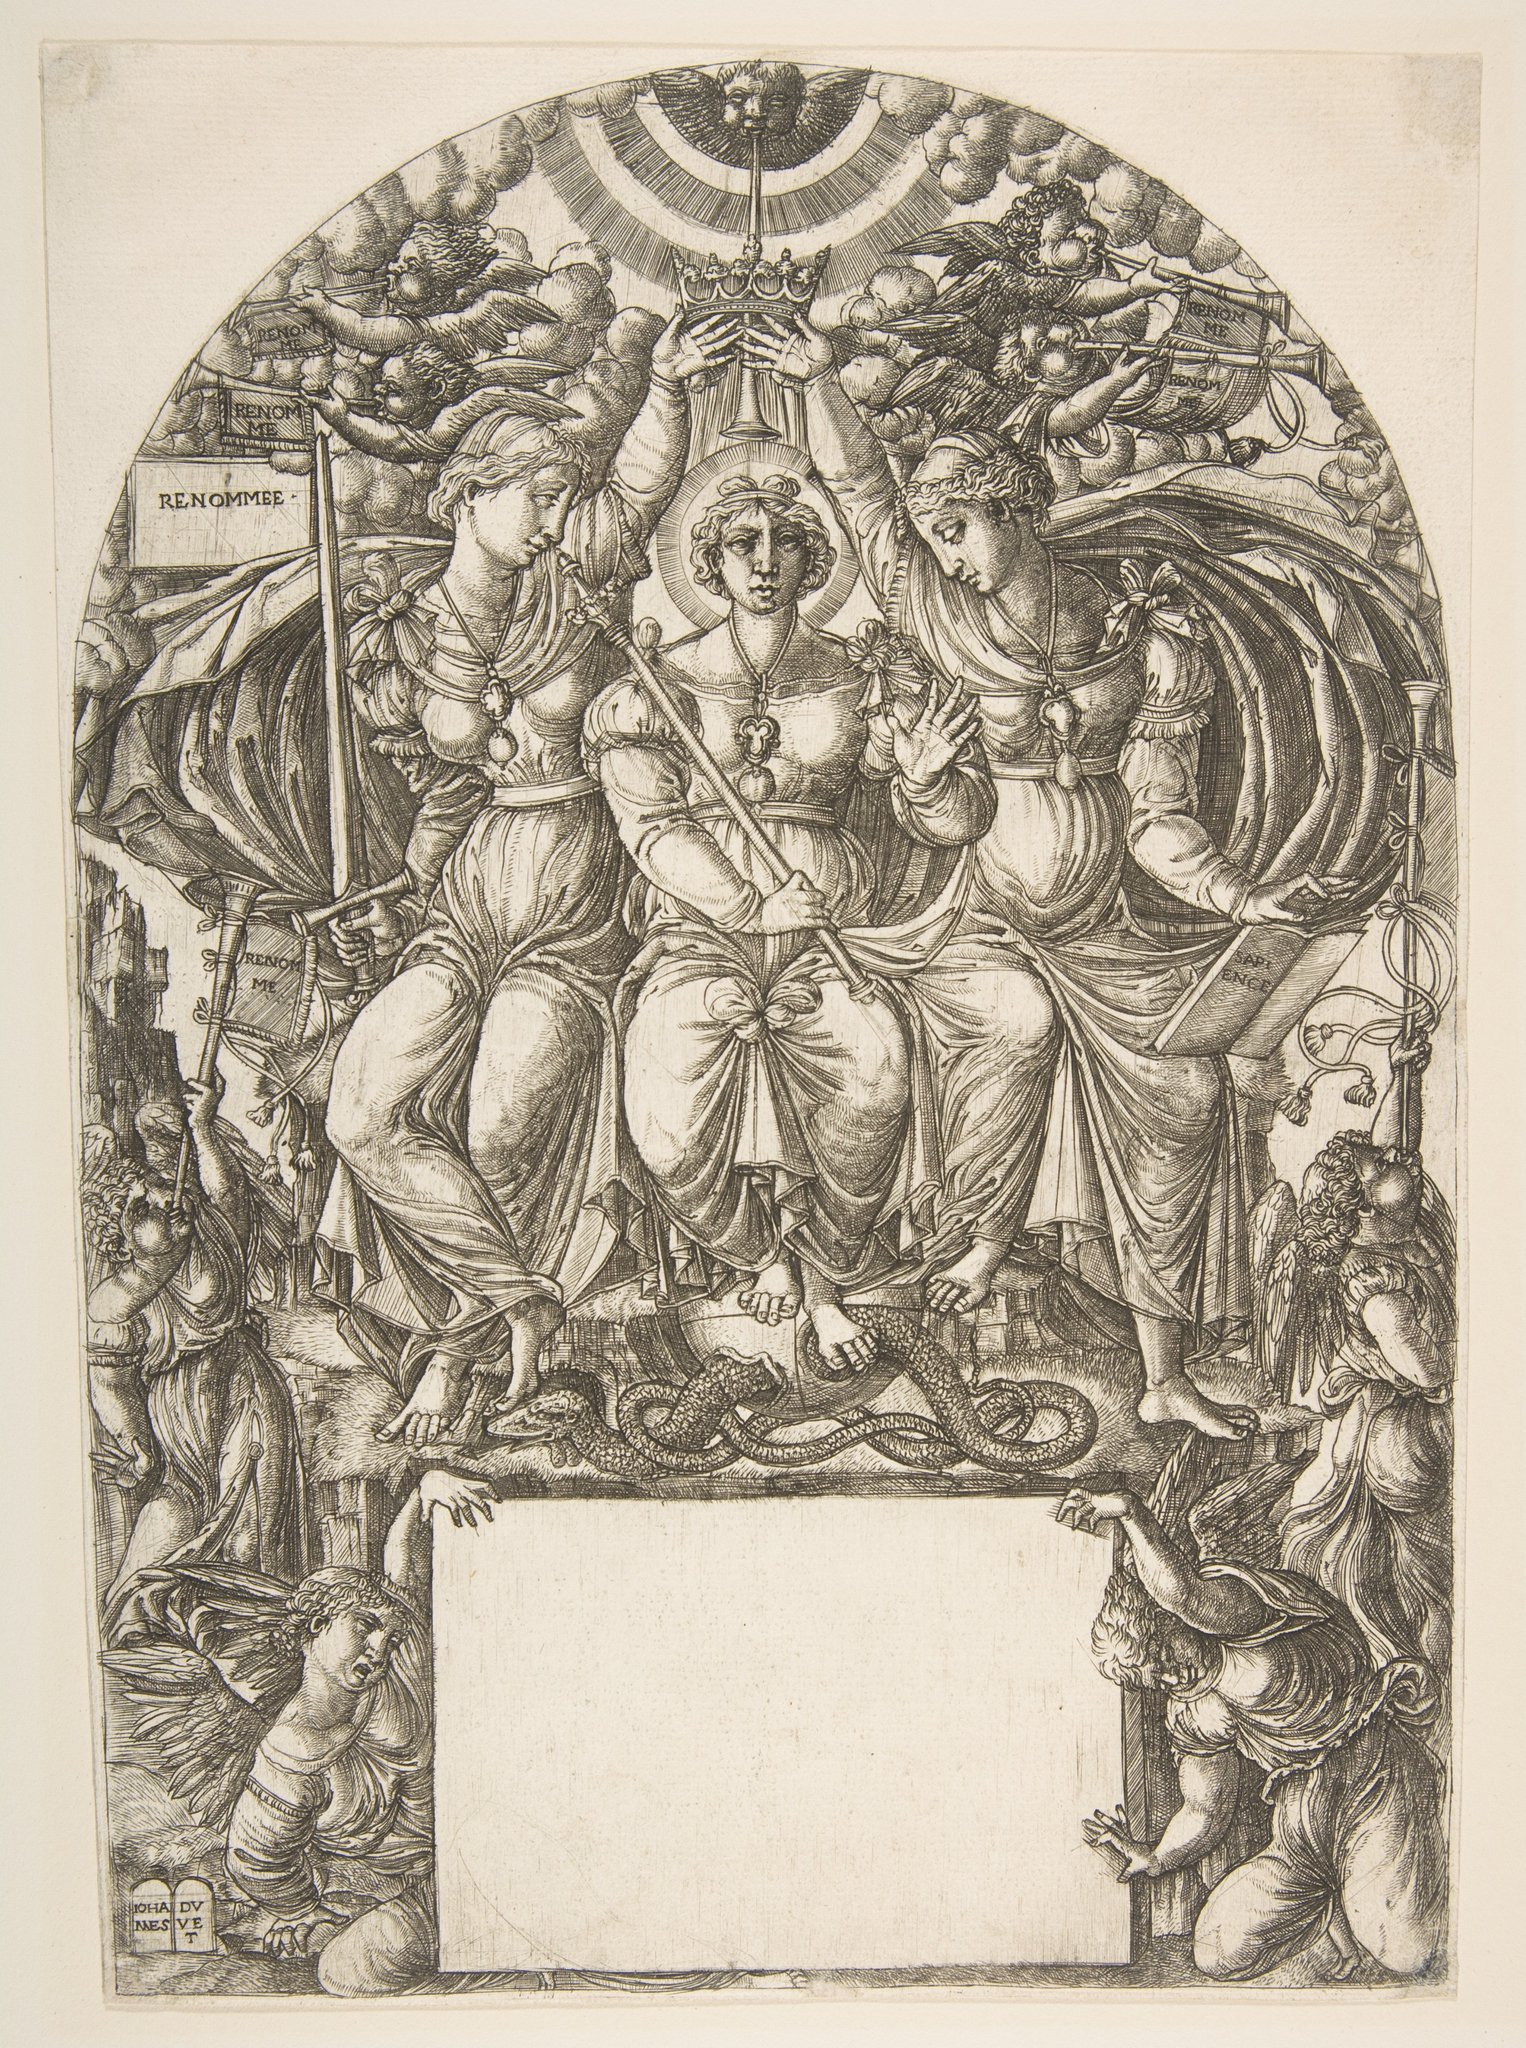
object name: print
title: La Majeste Royale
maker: jean duvet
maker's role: artist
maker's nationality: french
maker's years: 1485-1561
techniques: engraving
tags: swords,men,women,snakes